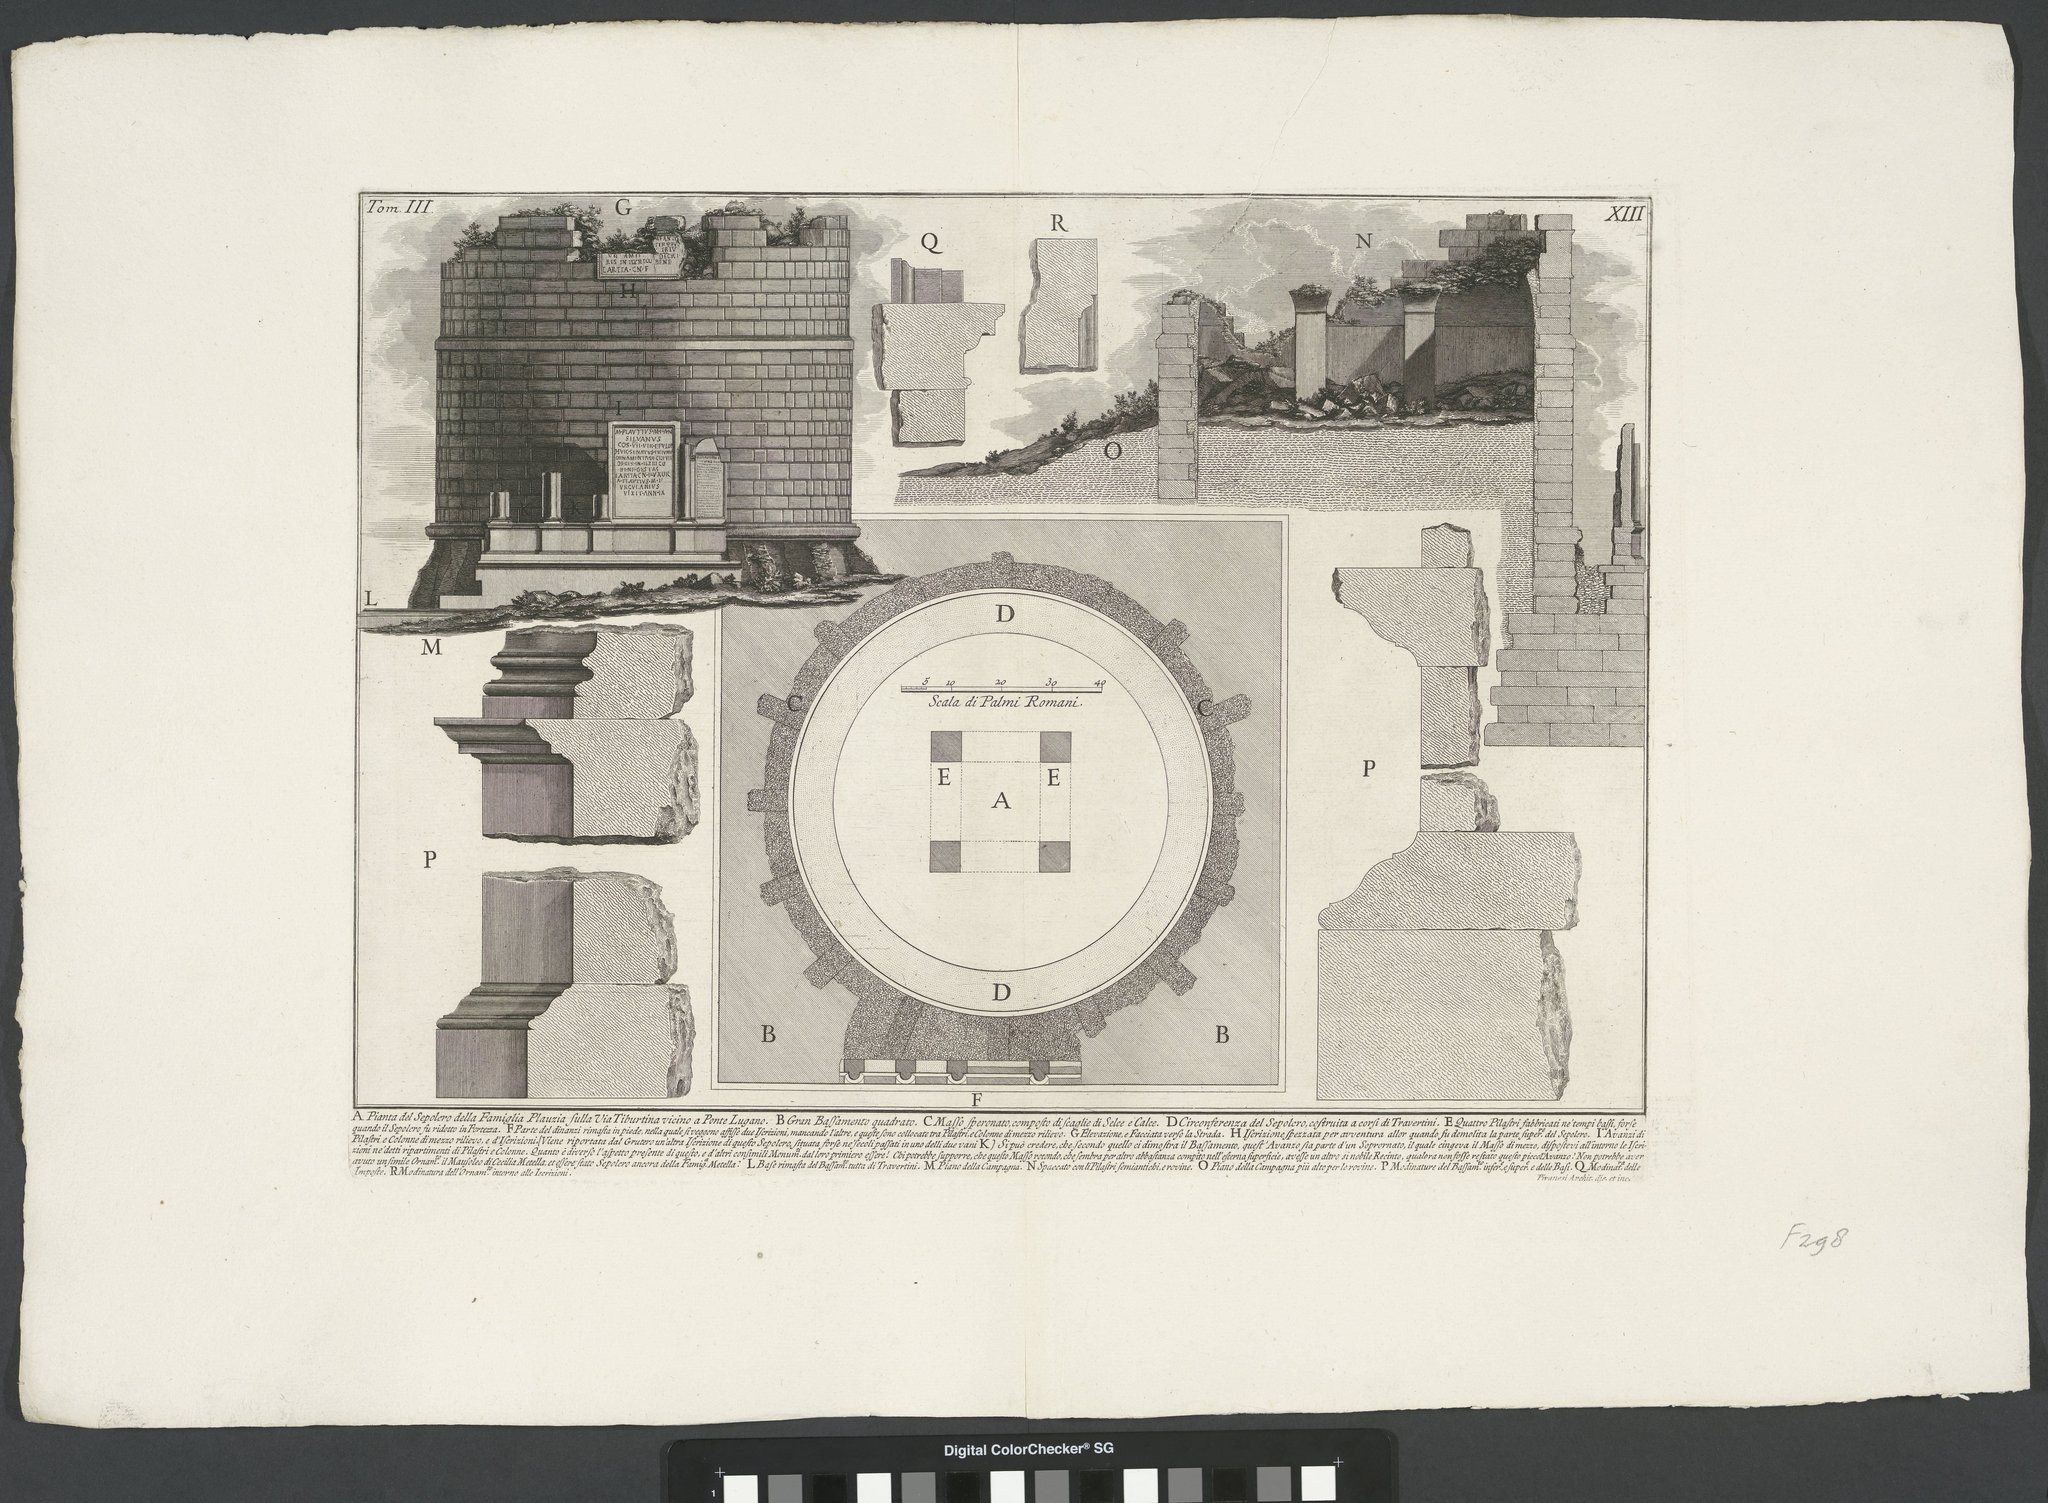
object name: print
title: Plattegrond, details en opstand van de graftombe van de Plauzi familie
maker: giovanni battista piranesi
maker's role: designer, draughtsman, print maker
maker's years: 1720-1778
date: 1756-1757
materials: paper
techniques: etching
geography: rome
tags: grave, tomb, plan ~ architecture, italy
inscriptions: collector's mark: Lugt 2228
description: Deze prent maakt deel uit van de serie 'Le Antichità Romane'. Piranesi deed meer dan acht jaar voorstudie voor deze 250 platen tellende serie die in vier volumes werd uitgegeven. Hij produceerde de prenten tussen ca. 1756 en 1757. De serie bevat ook prenten door of naar andere prentmakers, onder wie Francesco Bianchini en Girolamo Rossi.